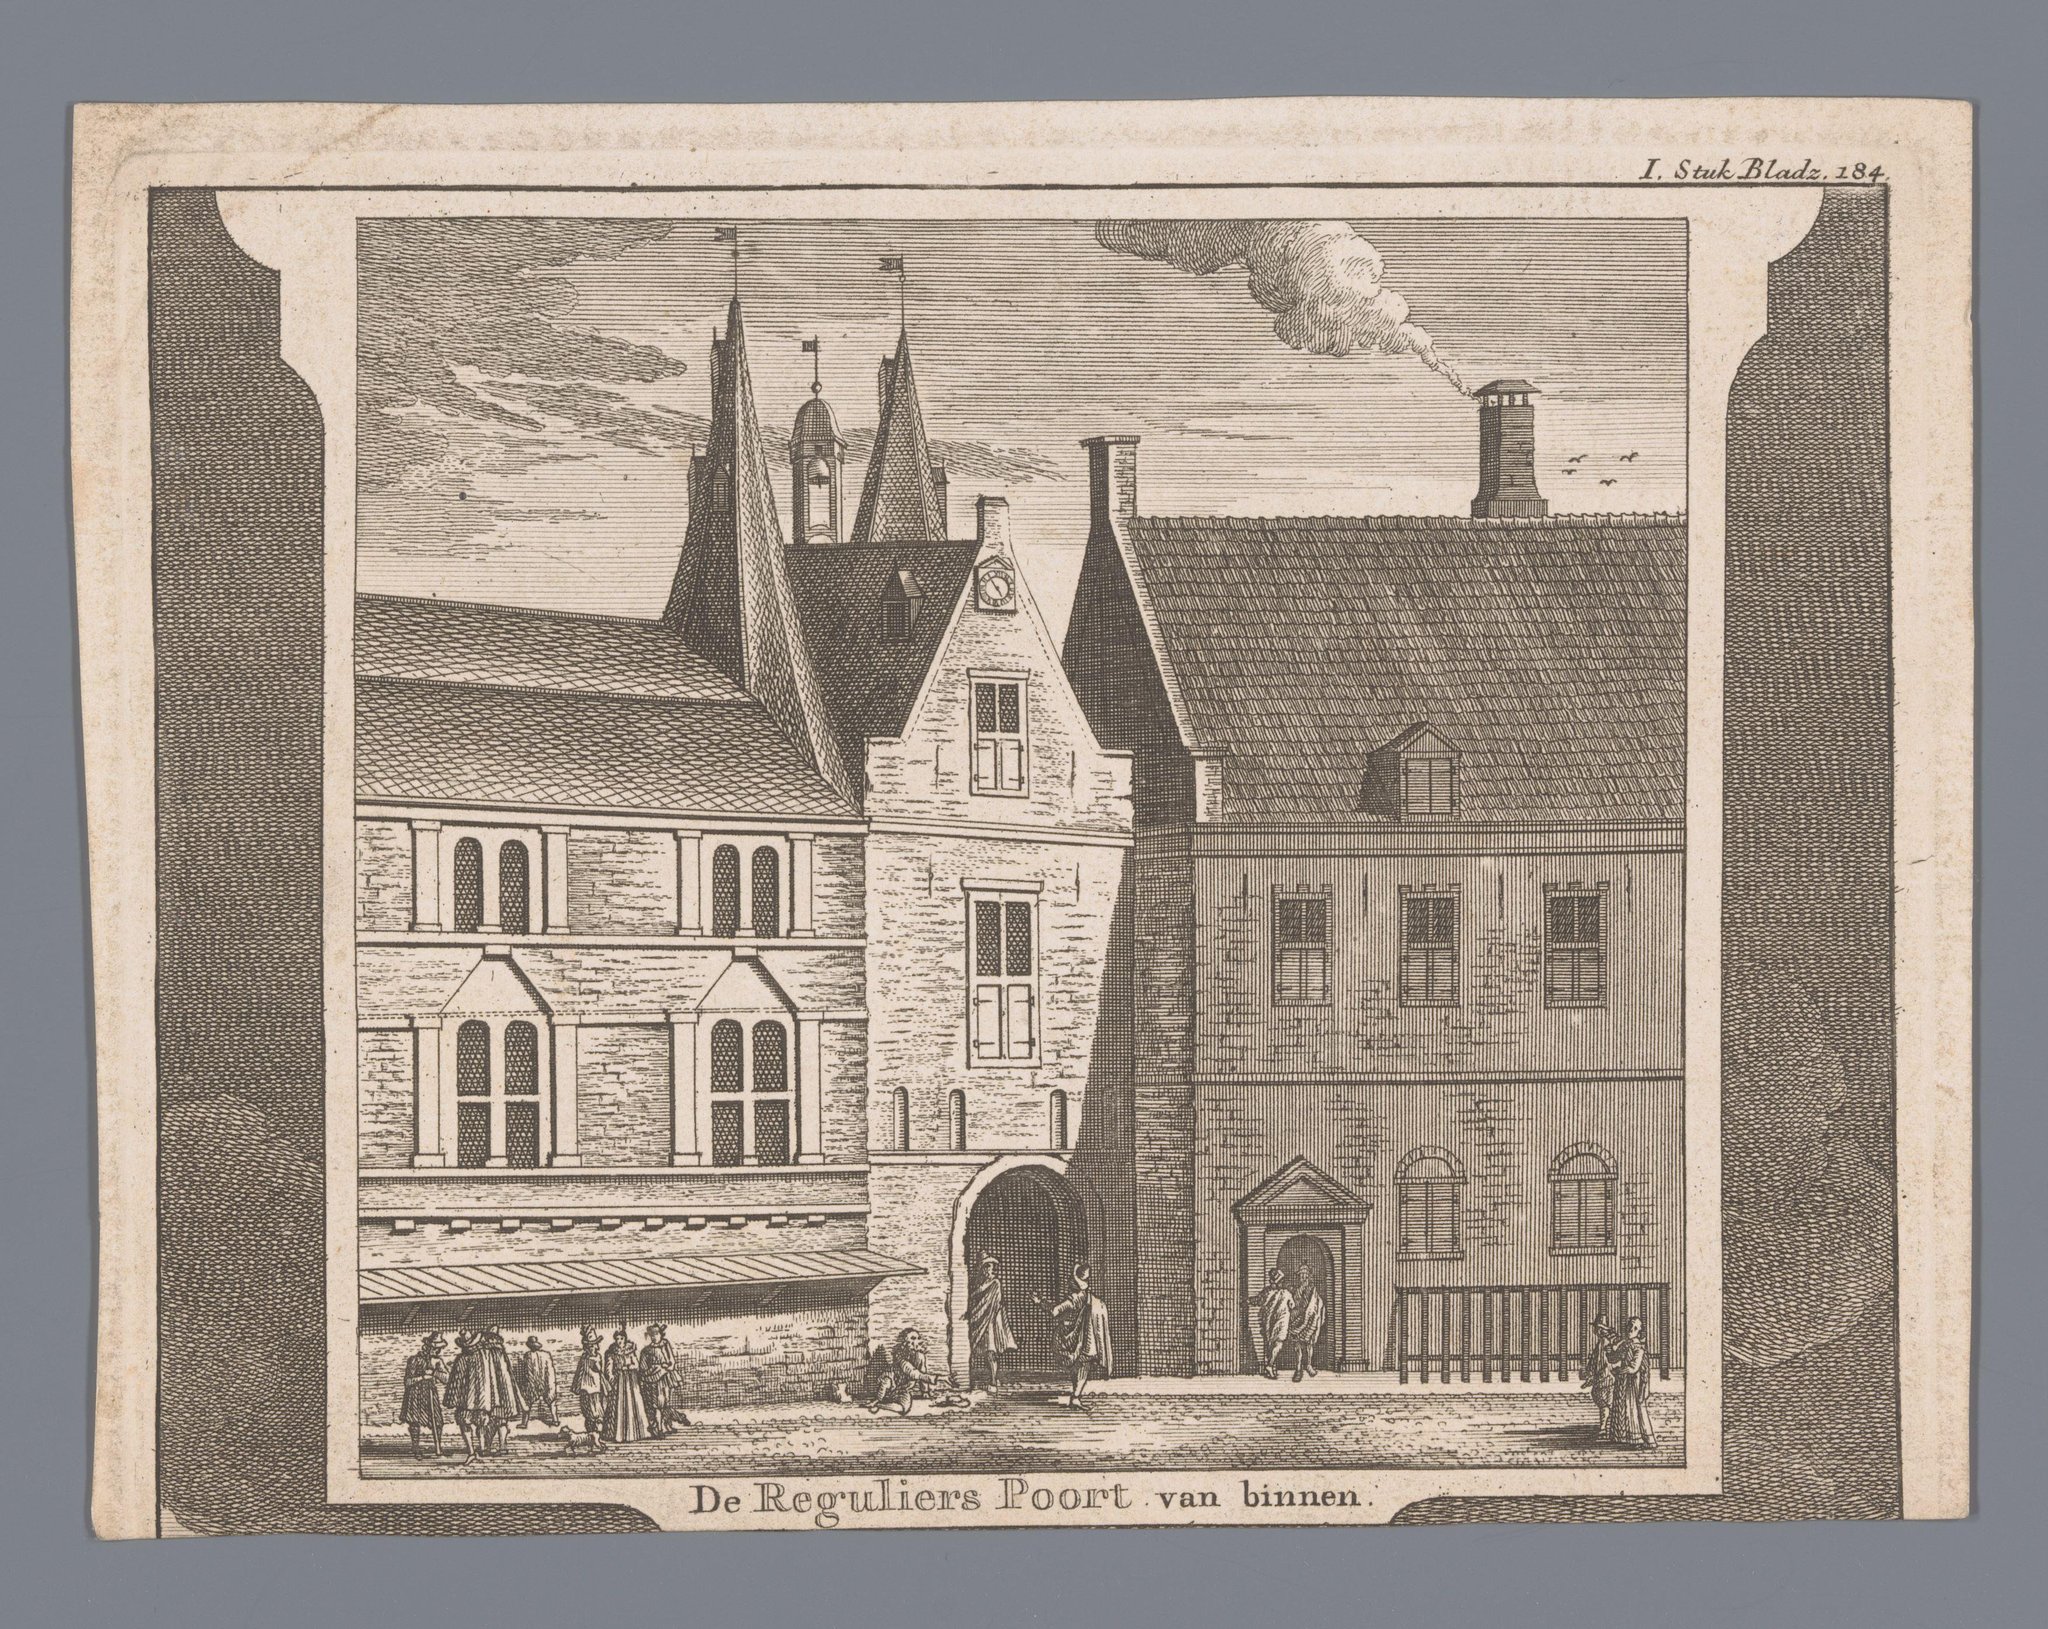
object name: book illustration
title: Gezicht op de binnenzijde van de Regulierspoort in Amsterdam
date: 1760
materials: paper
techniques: engraving, etching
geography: amsterdam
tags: city-gate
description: Prent uit: Wagenaar, Jan. Amsterdam, in zyne opkomst, aanwas, geschiedenissen (...). 2 dln. Amsterdam: Isaak Tirion, 1760, dl. 1, p. 184. Dit is de bovenste helft van een prent waarop twee gezichten van de Regulierspoort afgebeeld zijn. Zie bijv. RP-P-1931-117 voor een compleet exemplaar.